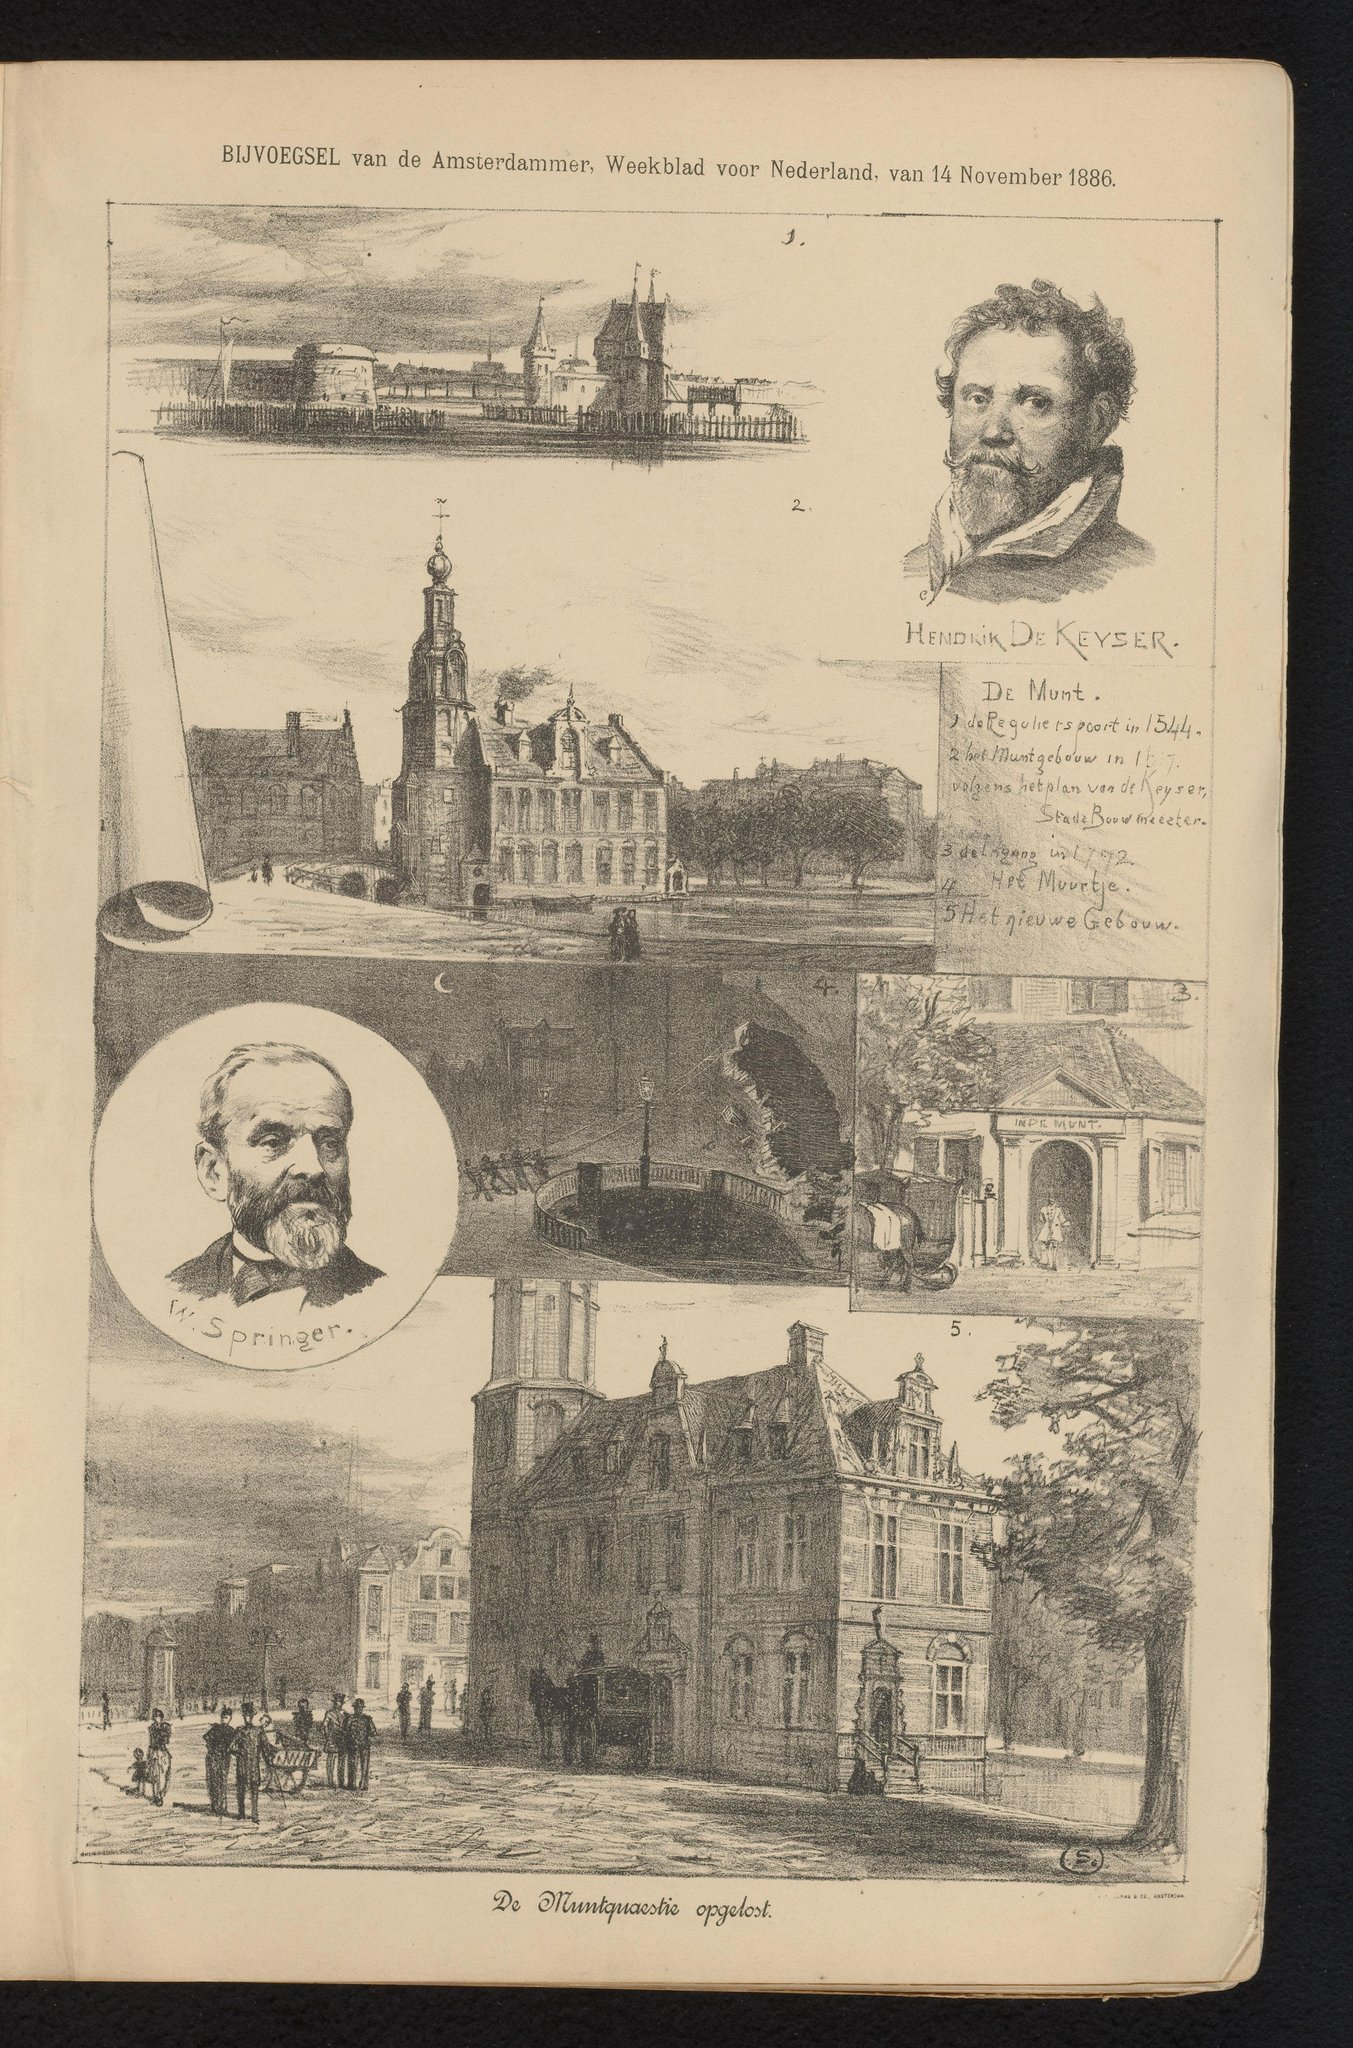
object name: print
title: De Muntquaestie opgelost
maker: willem steelink (ii)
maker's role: draughtsman, print maker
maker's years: 1856-1928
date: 1886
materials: paper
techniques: lithograph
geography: amsterdam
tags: utrecht, amsterdam, print maker, hendrick de keyser (i), historical persons, portrait, self-portrait of architect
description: De geschiedenis van het gebouw van de Munt te Amsterdam, met portretten van de architecten Hendrick de Keyser en Willem Springer.